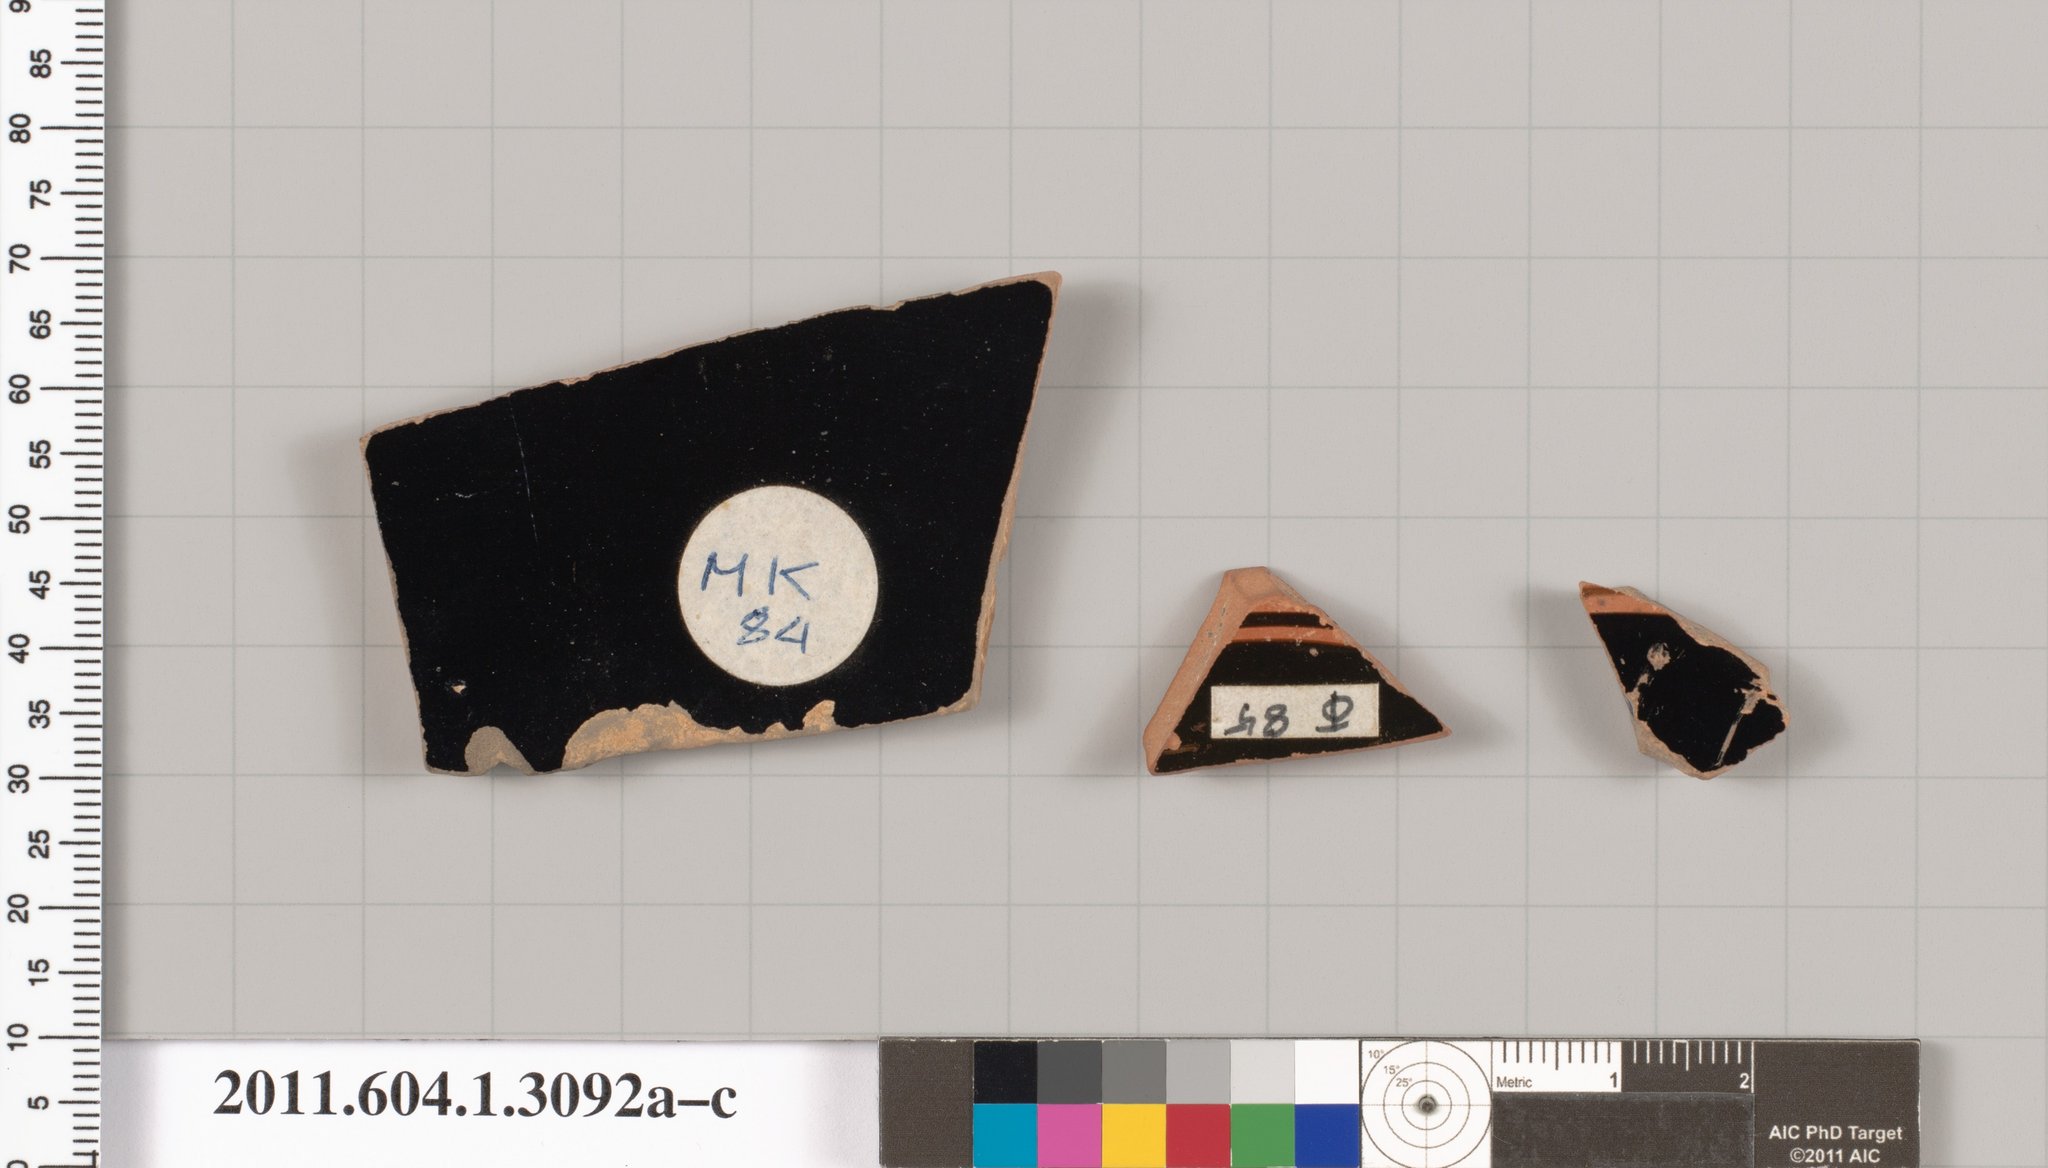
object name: kylix fragment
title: Terracotta fragments of kylikes (drinking cups)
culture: greek, attic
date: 600-401 BCE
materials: terracotta